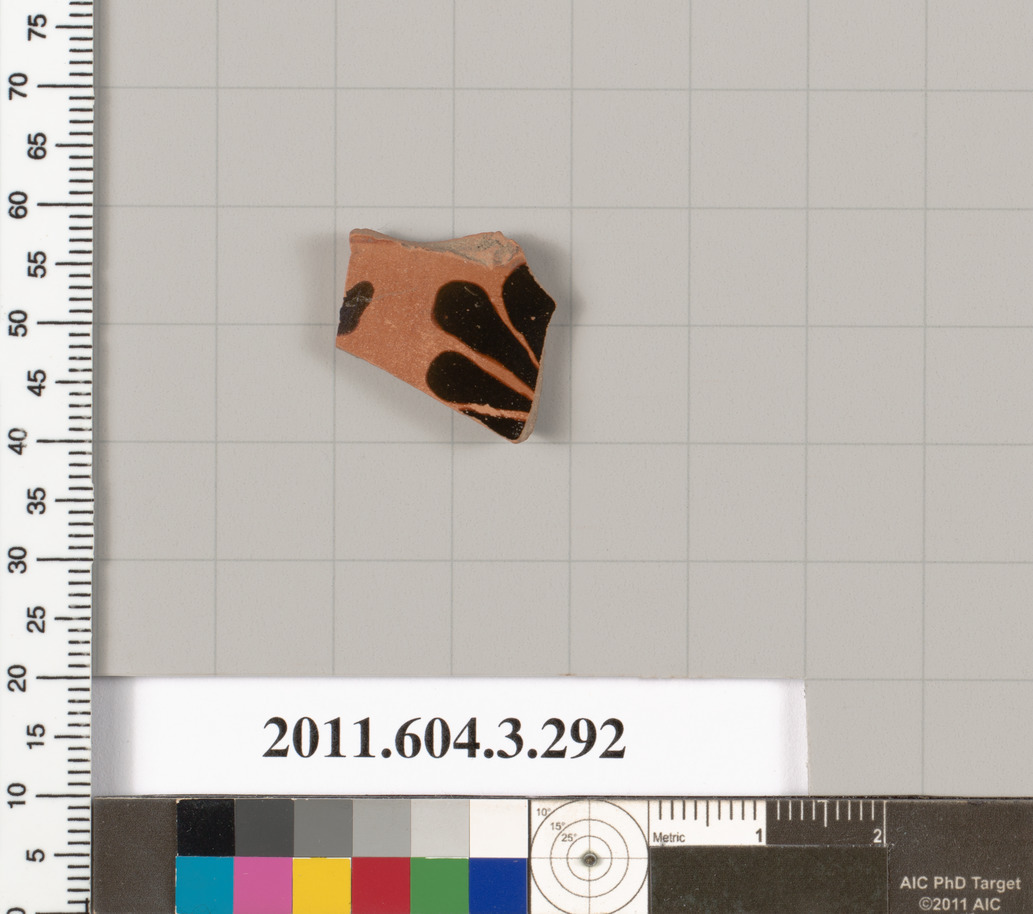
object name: neck amphora fragment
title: Terracotta fragment of a neck-amphora (jar)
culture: greek, attic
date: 534-468 BCE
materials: terracotta